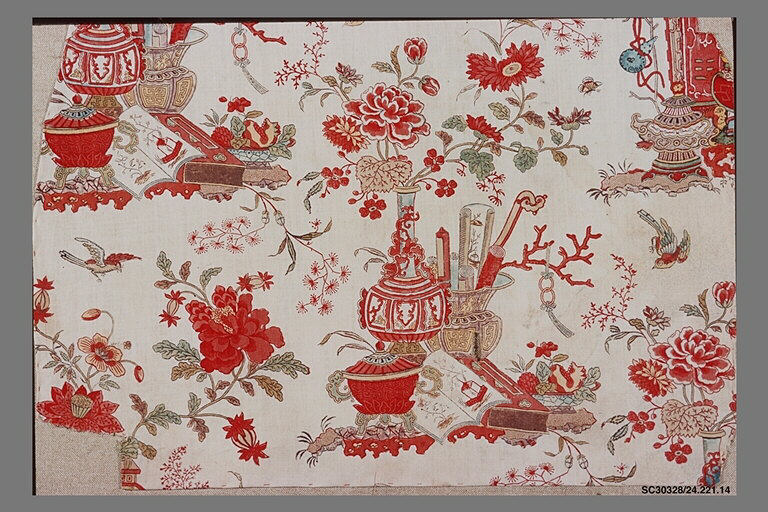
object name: piece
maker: oberkampf manufactory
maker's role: manufactory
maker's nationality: french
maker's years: 1760-1843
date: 1701-1800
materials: linen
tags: birds,books,flowers